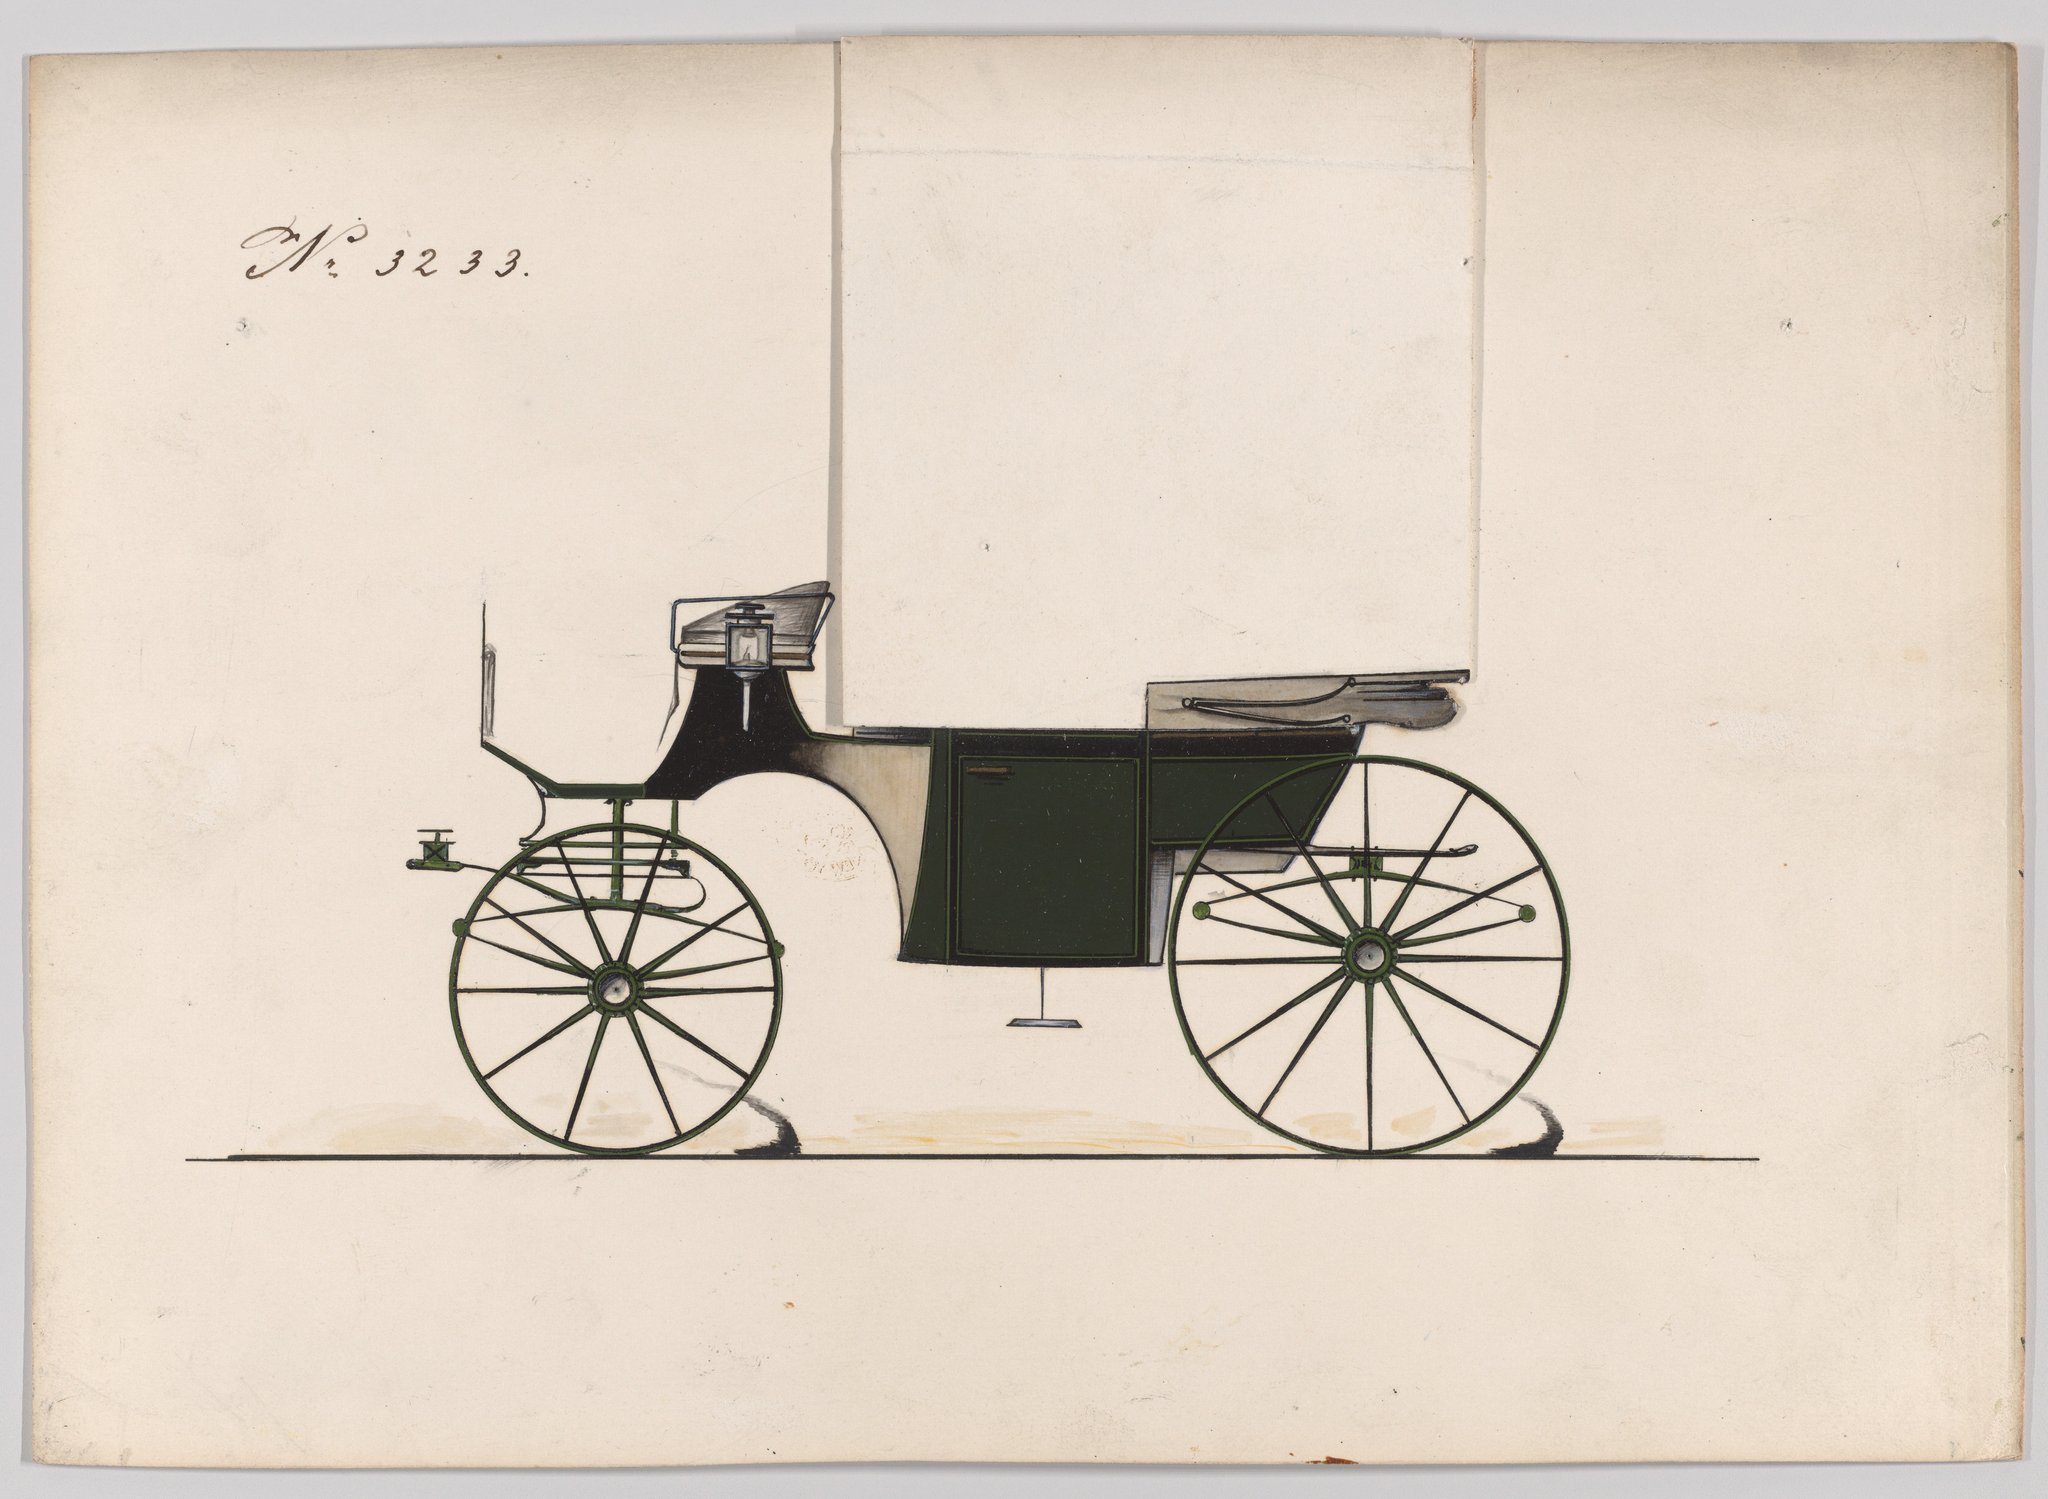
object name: drawing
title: Design for Landaulet, no. 3233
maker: brewster & co.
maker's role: manufacturer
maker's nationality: american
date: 1876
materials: gouache, gum arabic, ink, watercolor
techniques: pen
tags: carriages